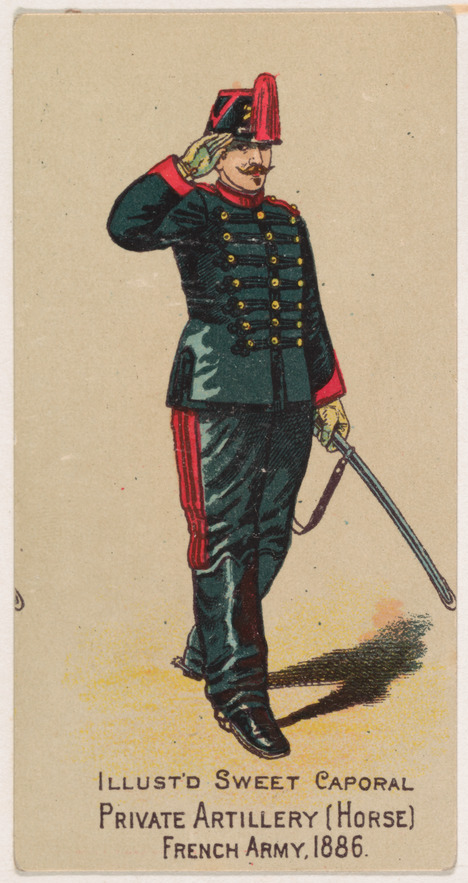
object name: print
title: Private, Artillery (Horse), French Army, 1886, from the Military Series (N224) issued by Kinney Tobacco Company to promote Sweet Caporal Cigarettes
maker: kinney brothers tobacco company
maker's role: publisher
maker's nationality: american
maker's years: 1869-2011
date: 1888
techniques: color lithograph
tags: soldiers,men